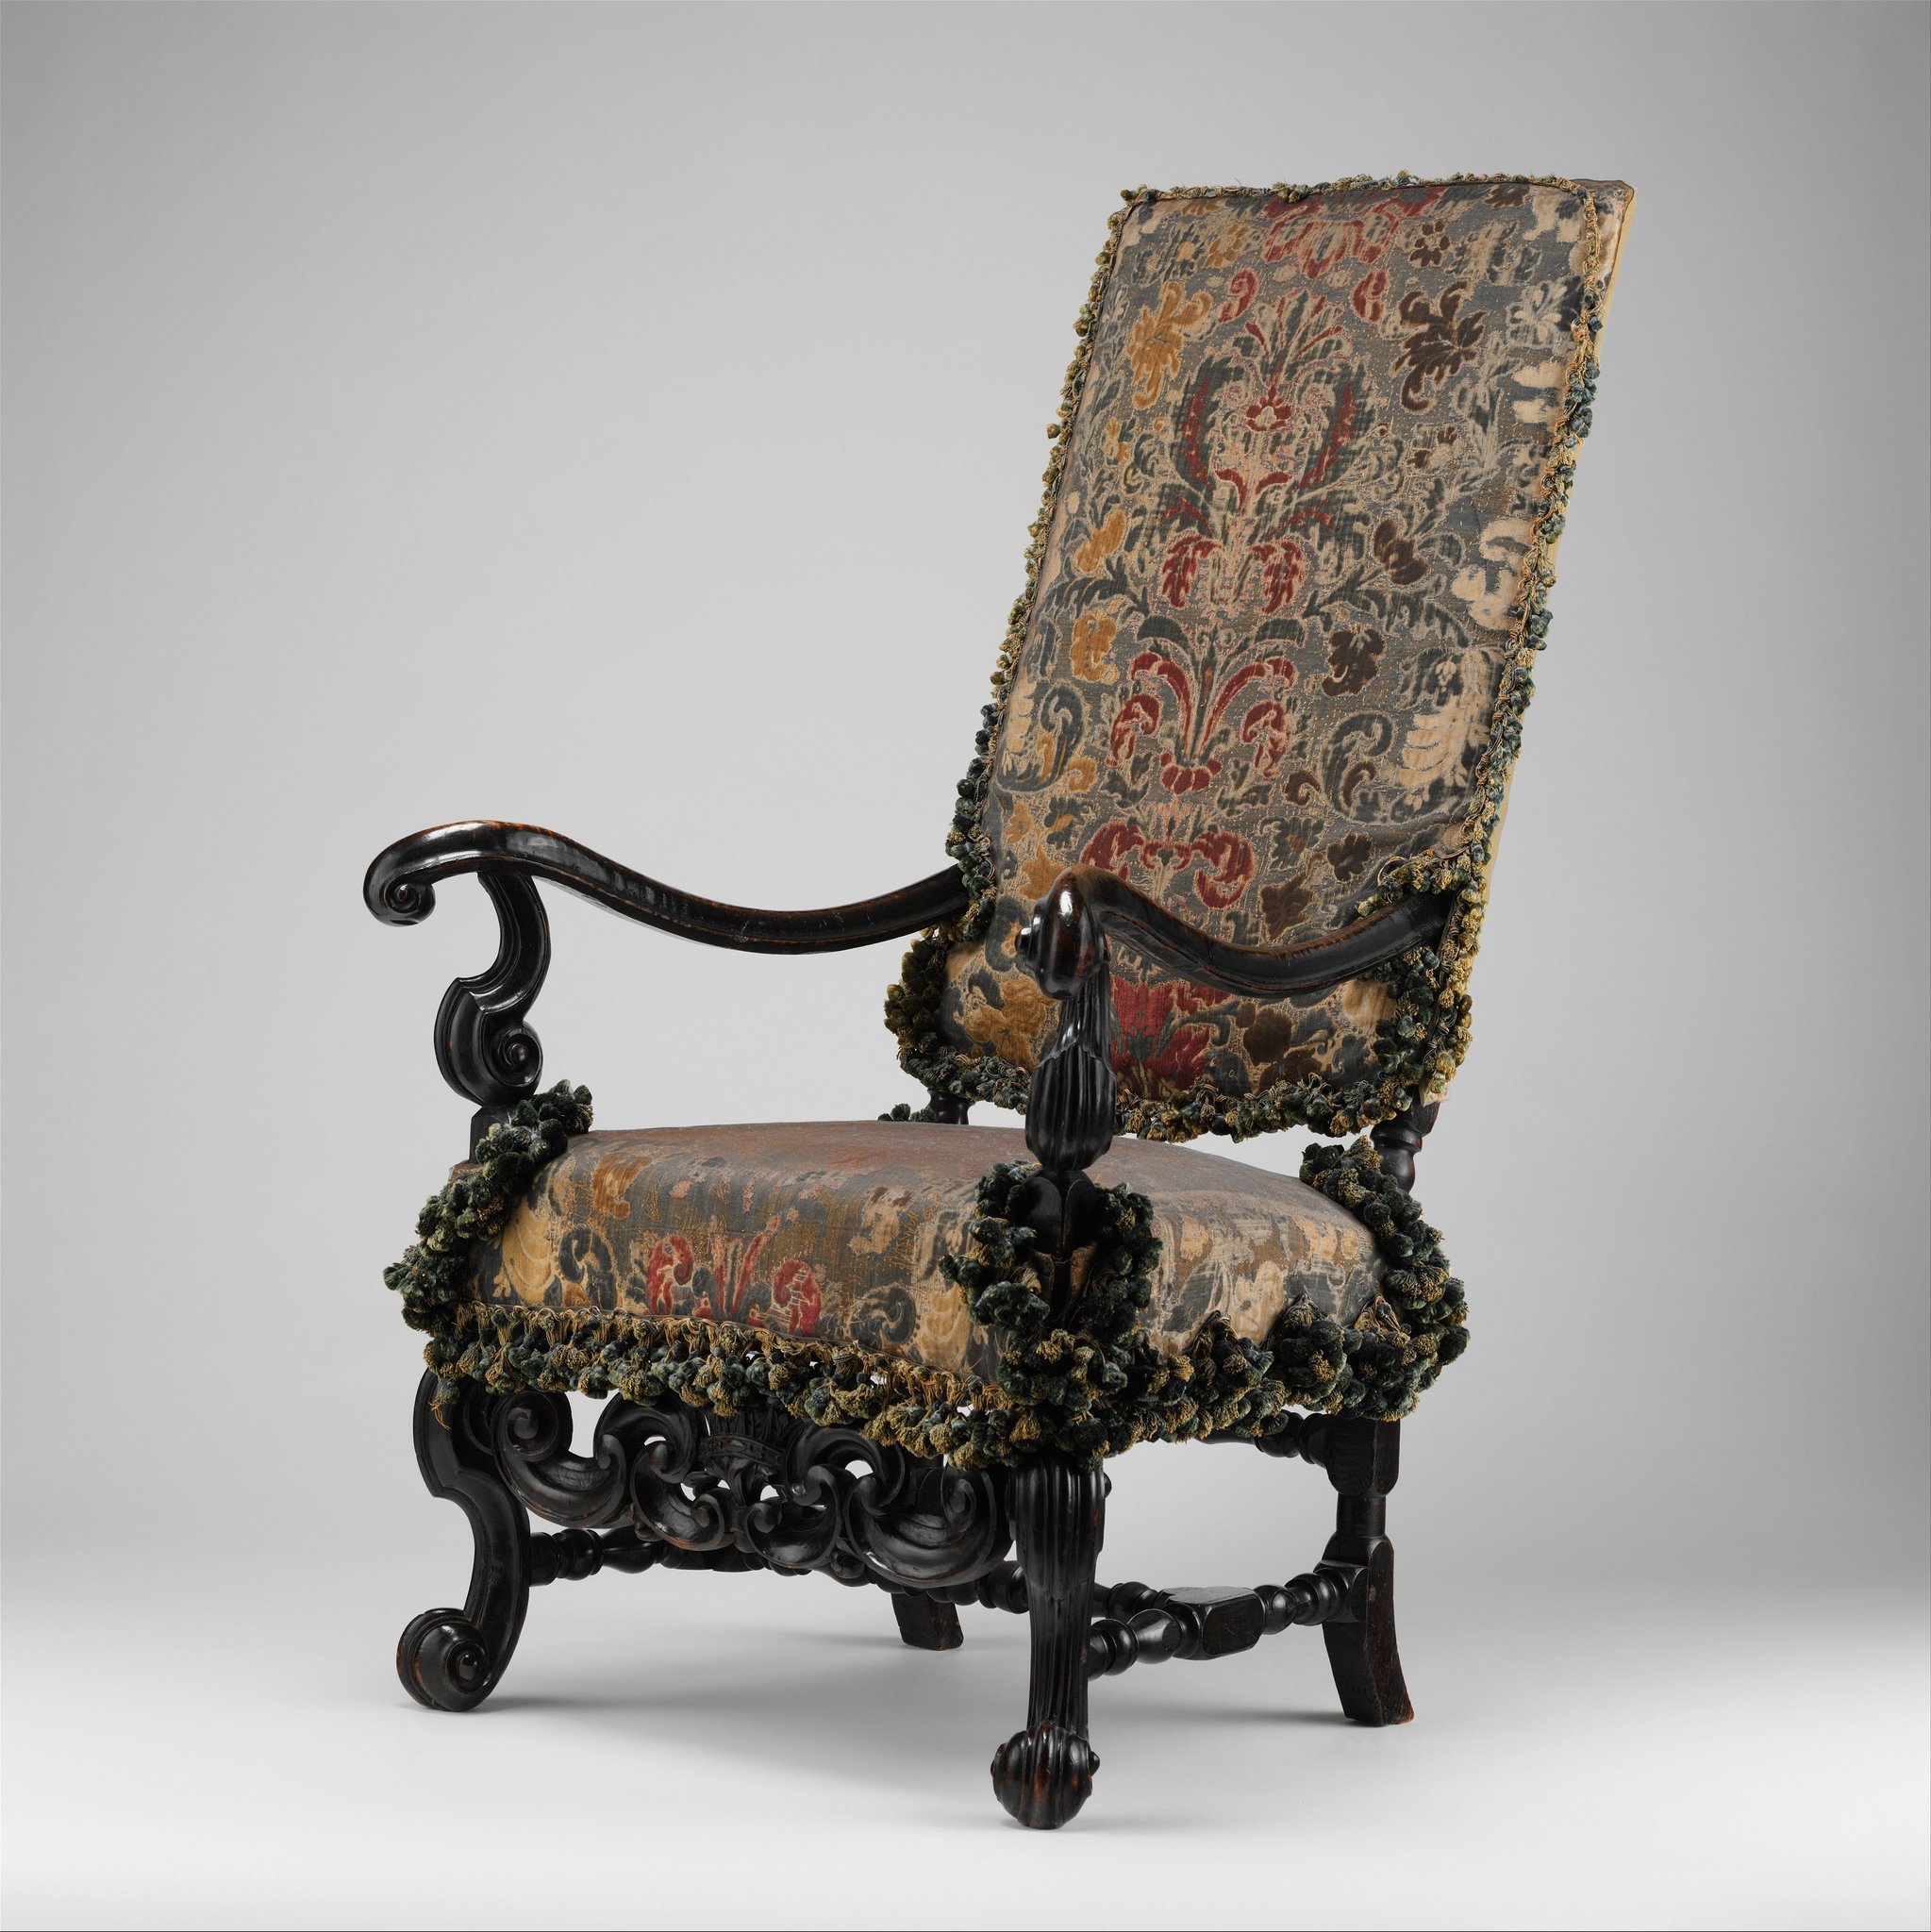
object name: armchair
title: Upholstered armchair, originally from a set of eight, from Burley-on-the-Hill, Rutland (one of a pair)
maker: thomas roberts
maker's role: maker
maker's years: 1685-1714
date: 1689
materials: wood, velvet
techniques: cutting